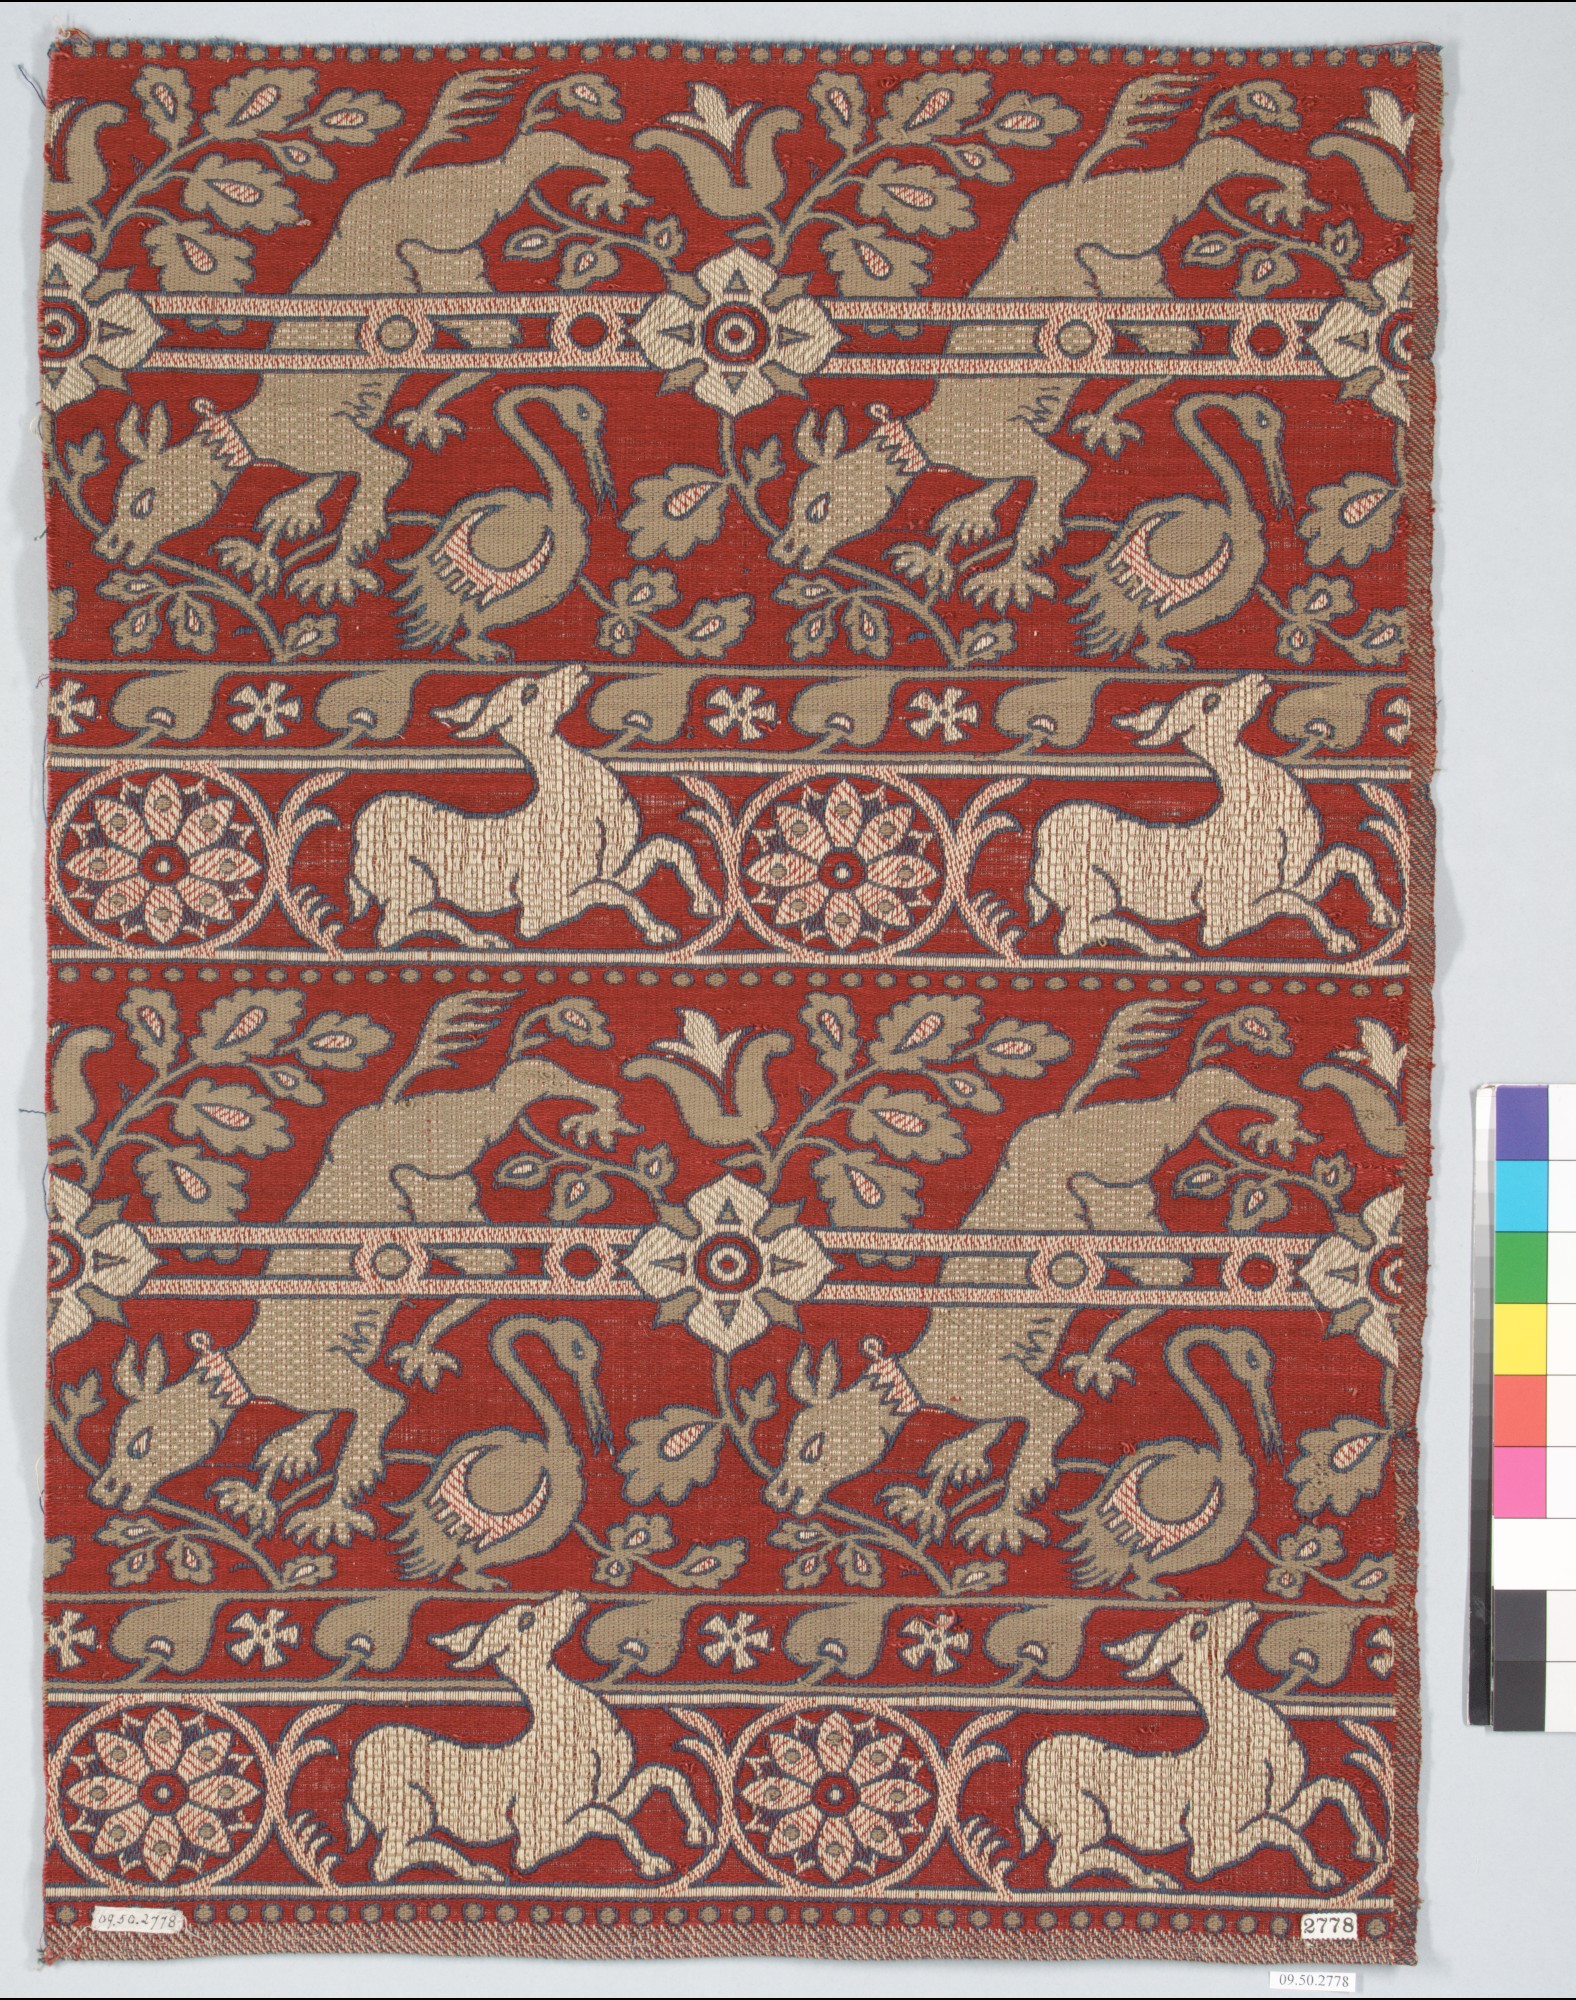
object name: piece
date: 1801-1900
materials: wool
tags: animals,birds,flowers